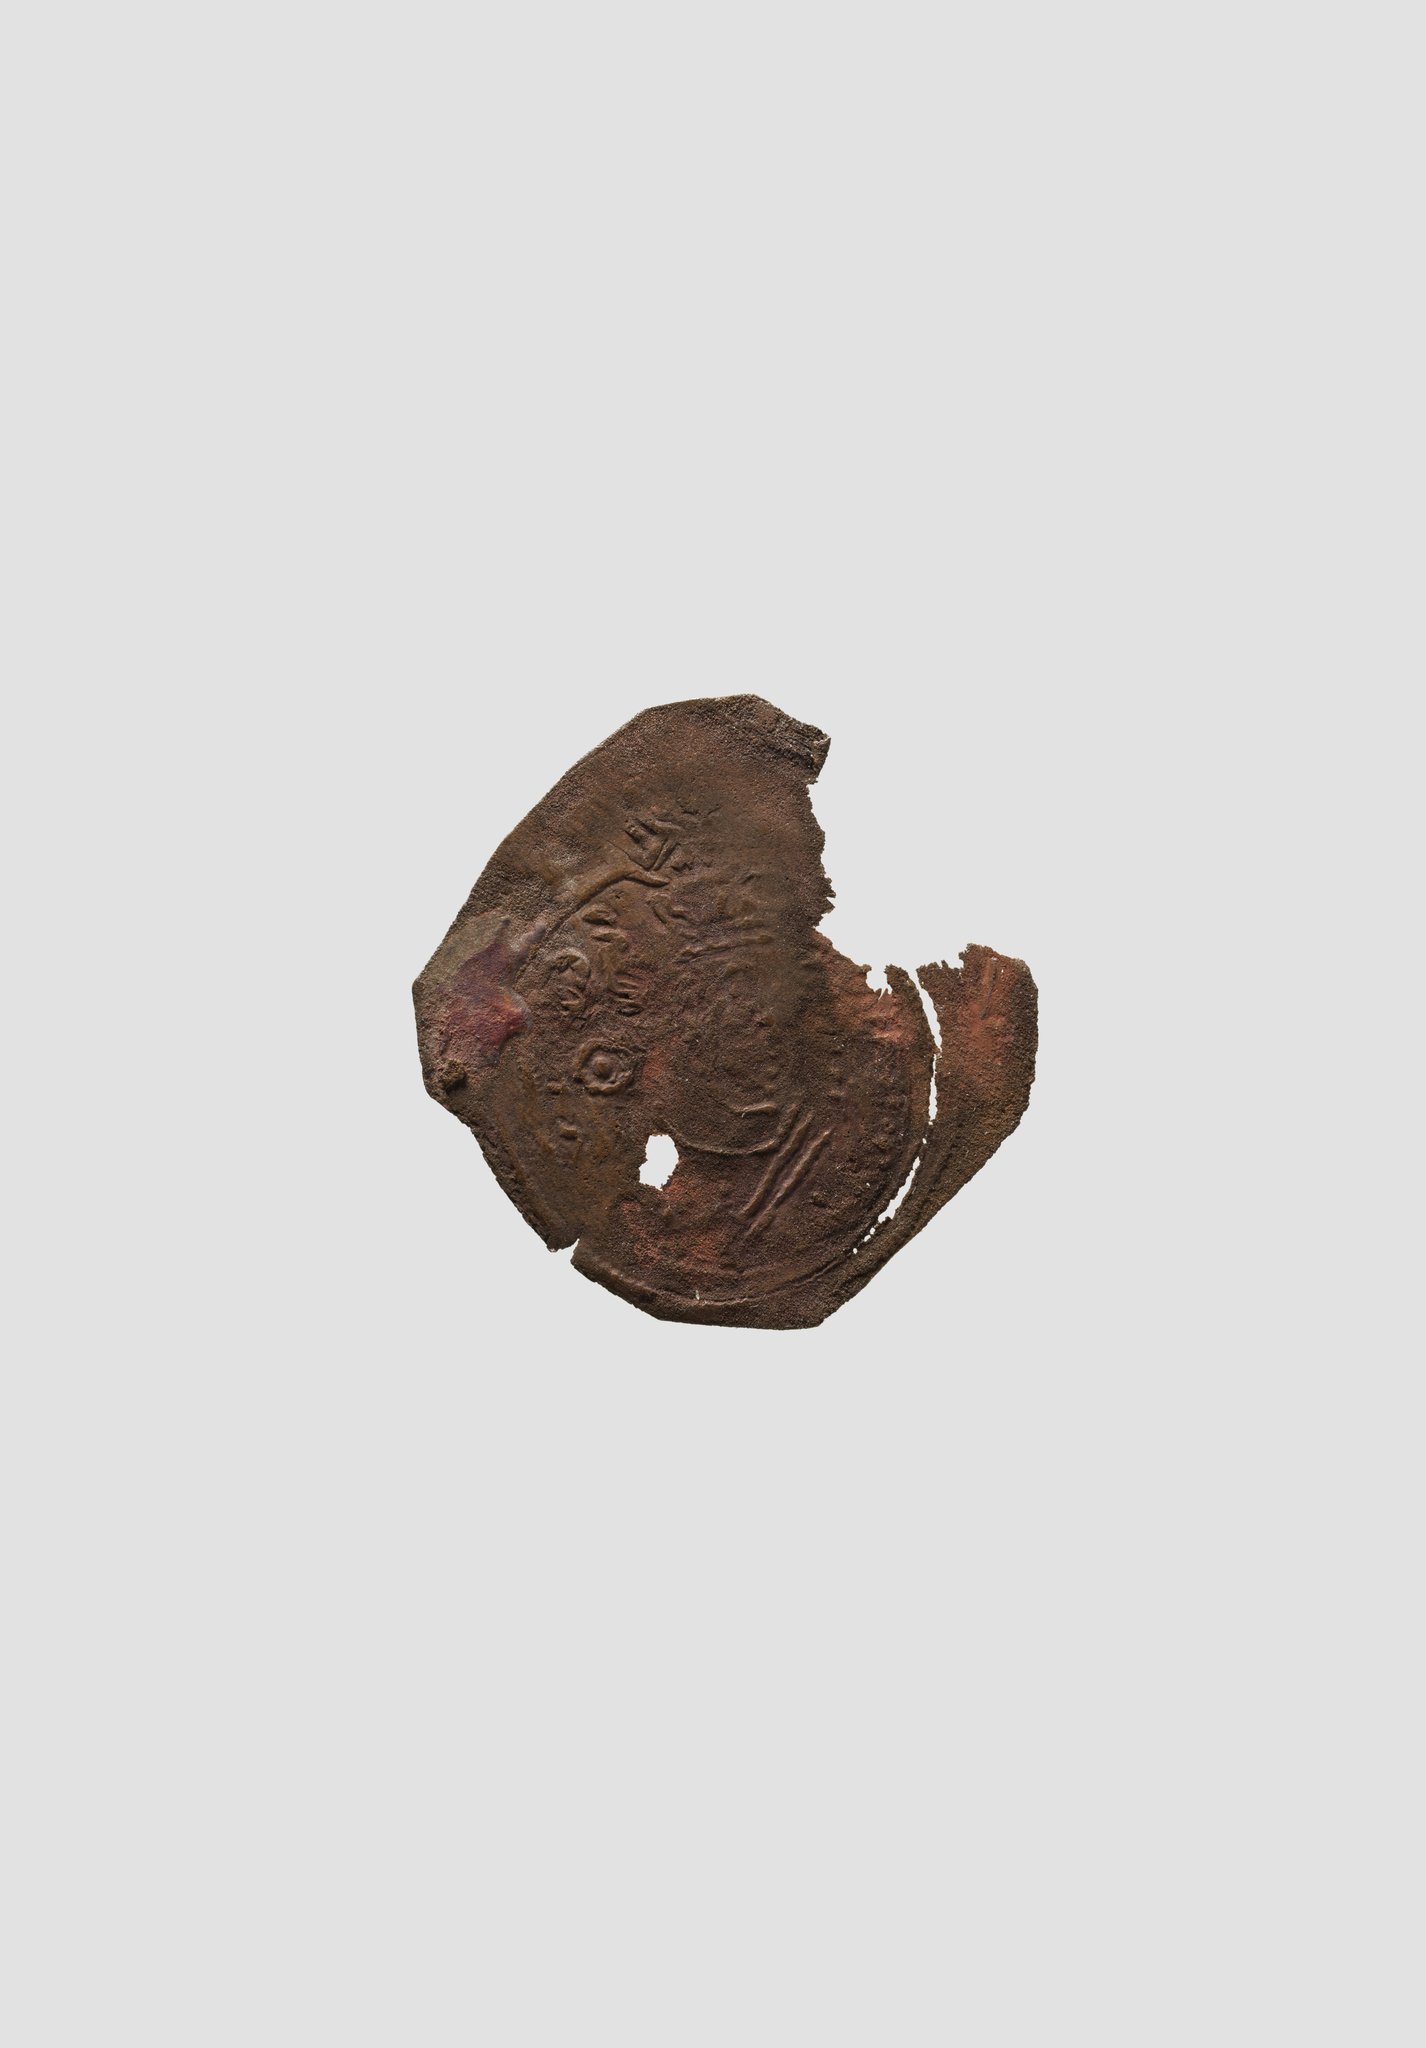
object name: coin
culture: islamic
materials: copper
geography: iran